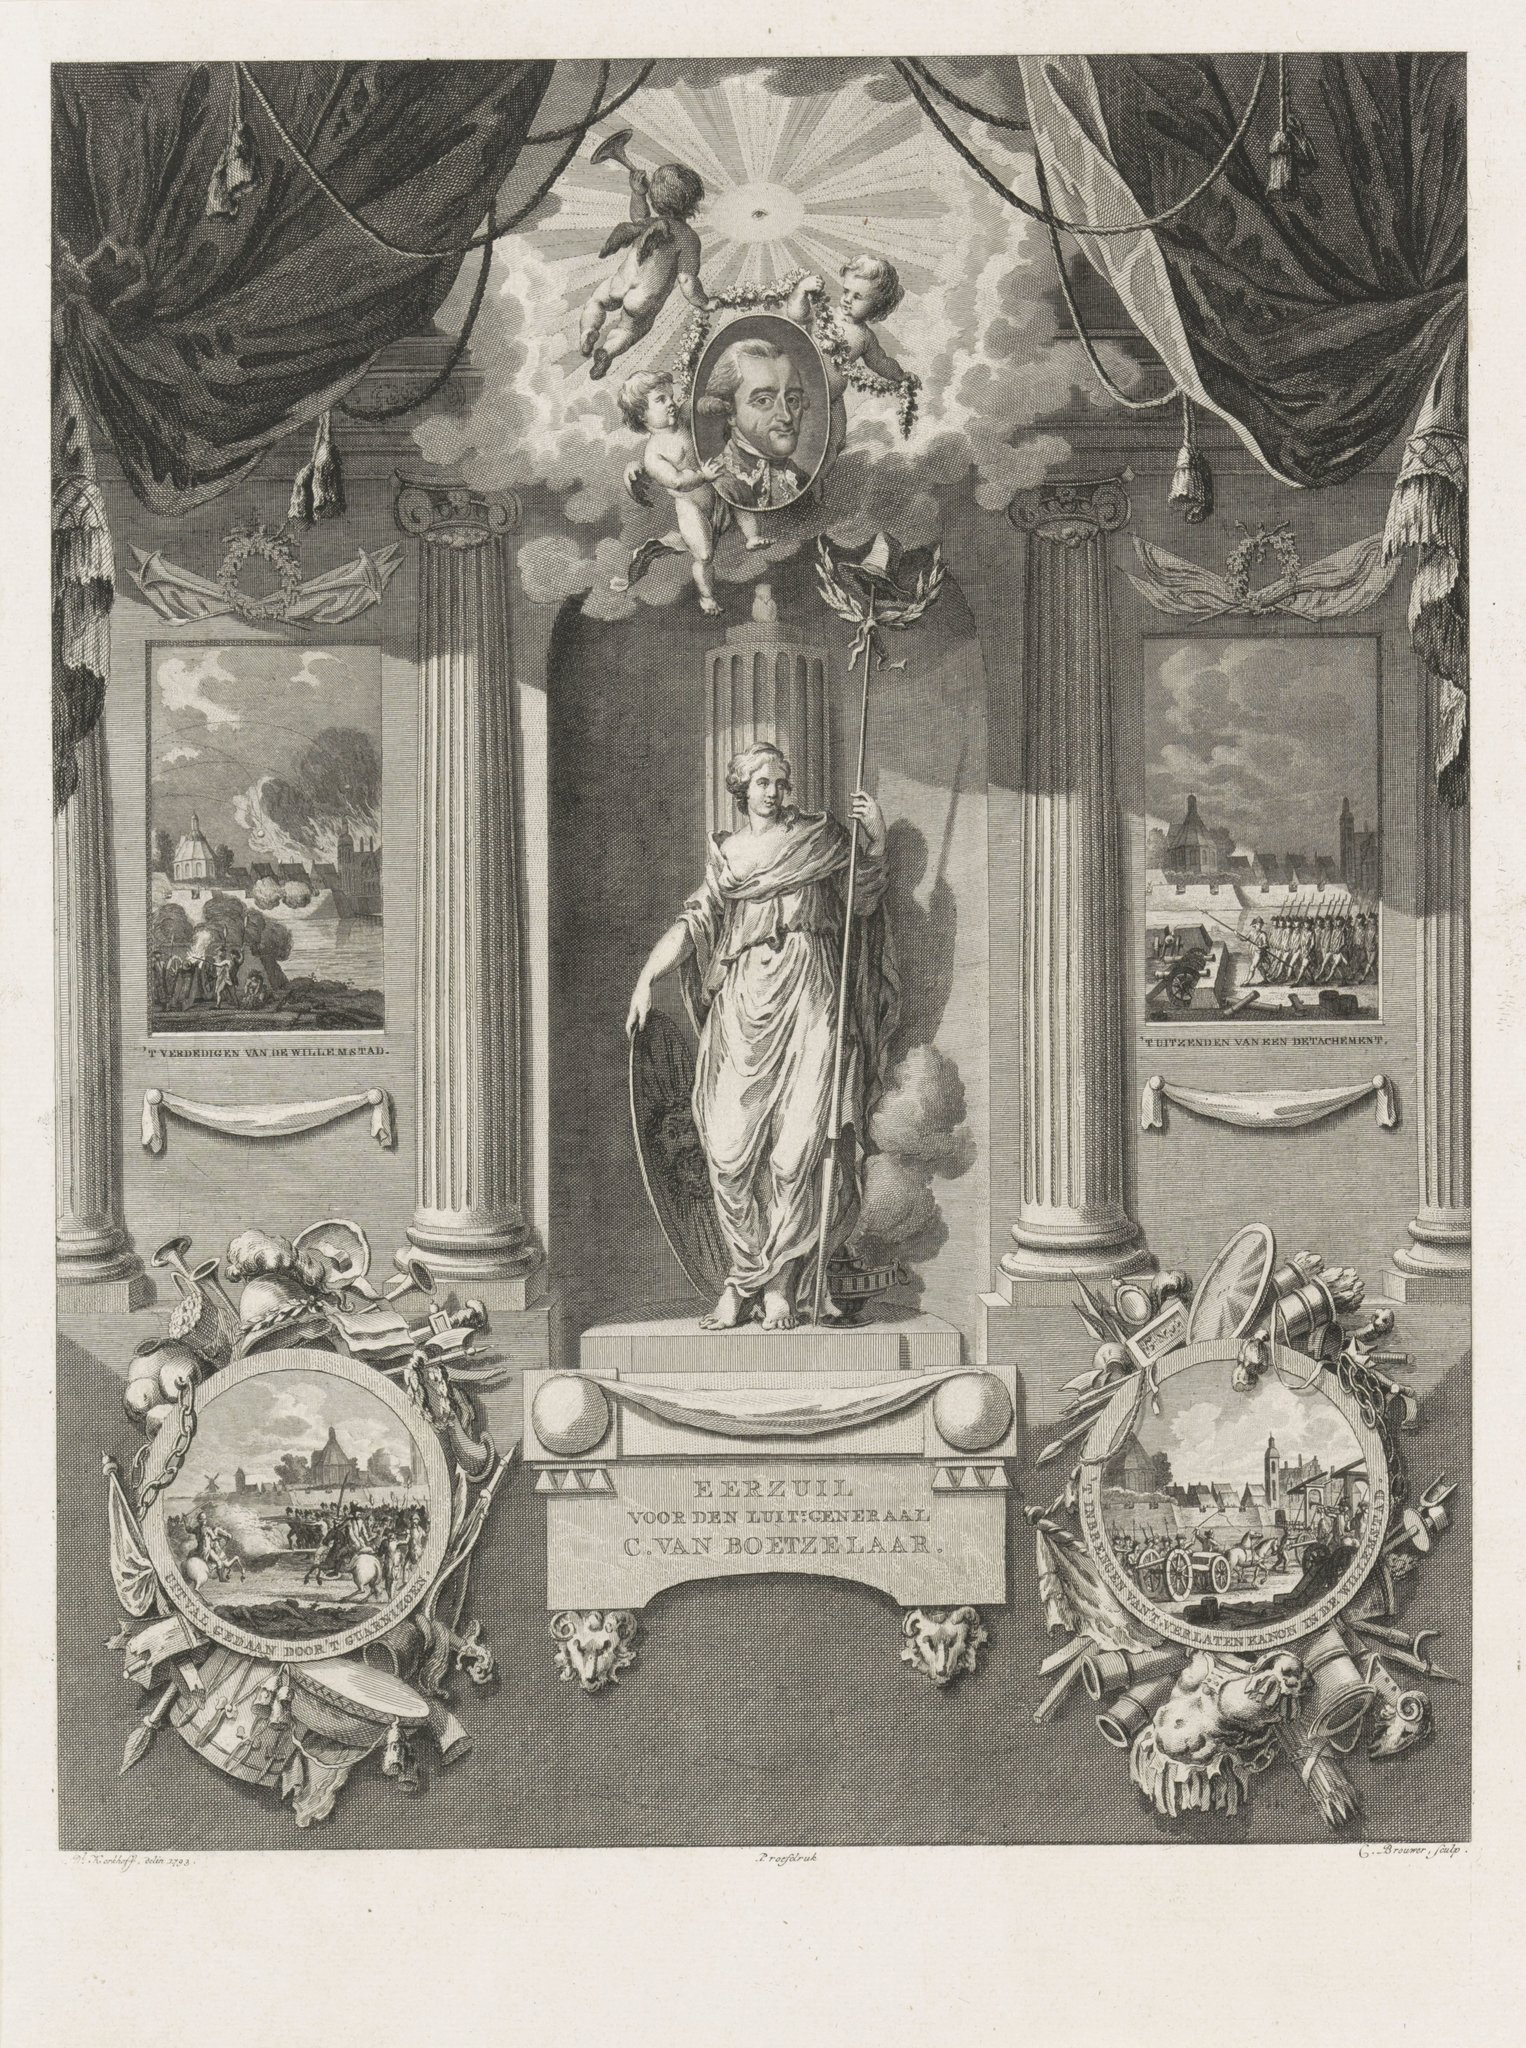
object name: print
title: Erezuil voor luitenant-generaal Carel Baron van Boetzelaer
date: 1793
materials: paper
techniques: engraving, etching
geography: northern netherlands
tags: the hague, siege, position war, freedom, liberty; 'libertà' (ripa) (+ abstract concept represented by female figure)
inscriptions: collector's mark: Lugt 2228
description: Erezuil voor luitenant-generaal Carel Baron van Boetzelaer, belast met de verdediging van Willemstad tijdens het beleg door het Franse leger 27 februari - 15 maart 1793. Nis met een standbeeld van de Vrijheid, bovenaan putti met een portret van de baron. Links en rechts vier voorstellingen van gebeurtenissen tijdens het beleg.